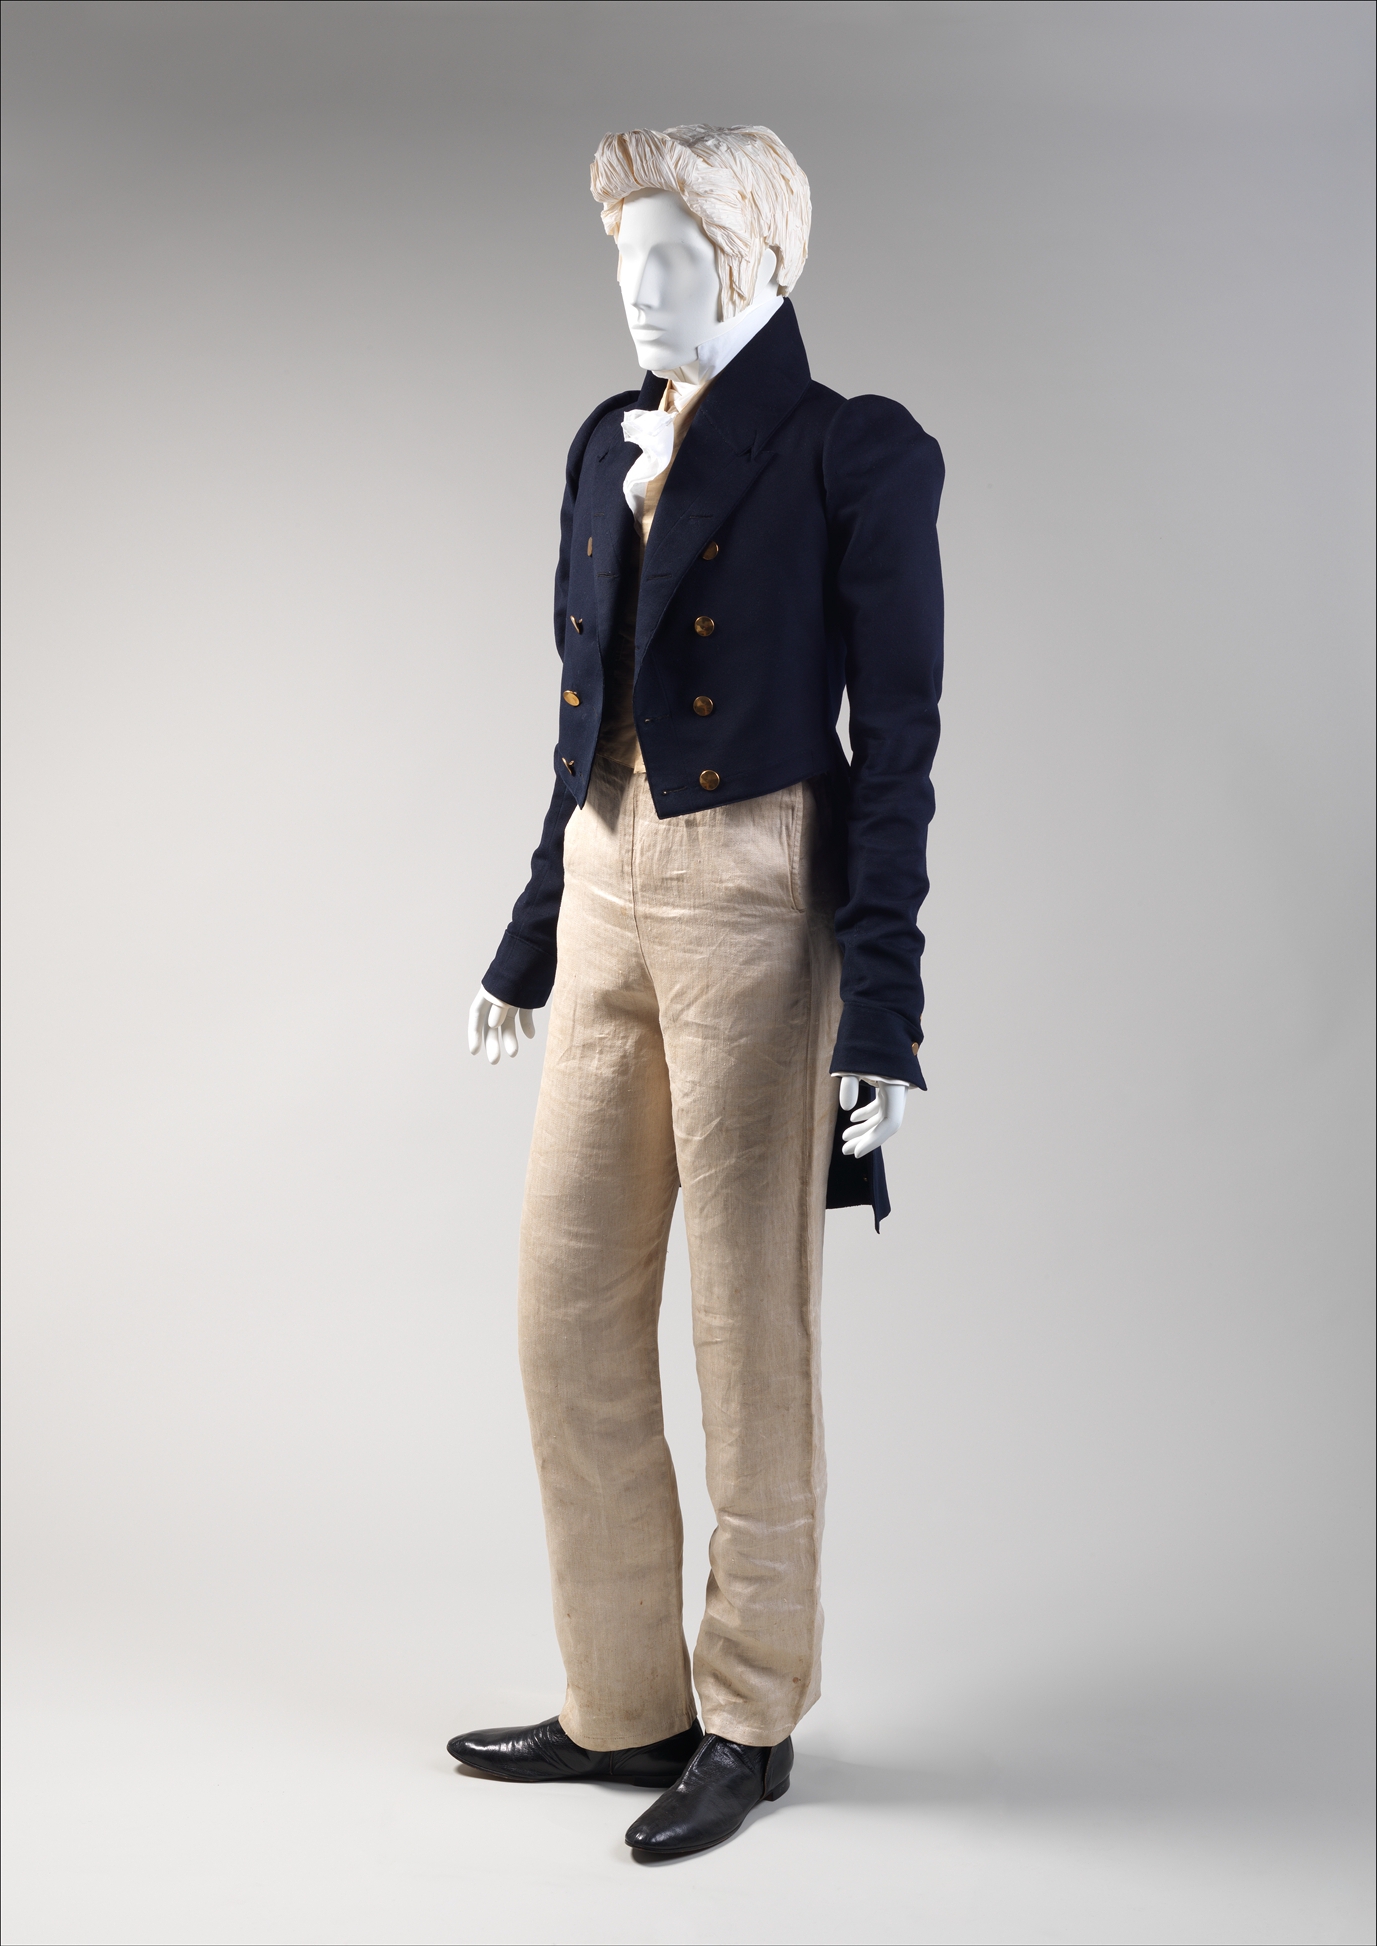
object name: ensemble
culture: american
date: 1820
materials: cotton, linen, silk, wool